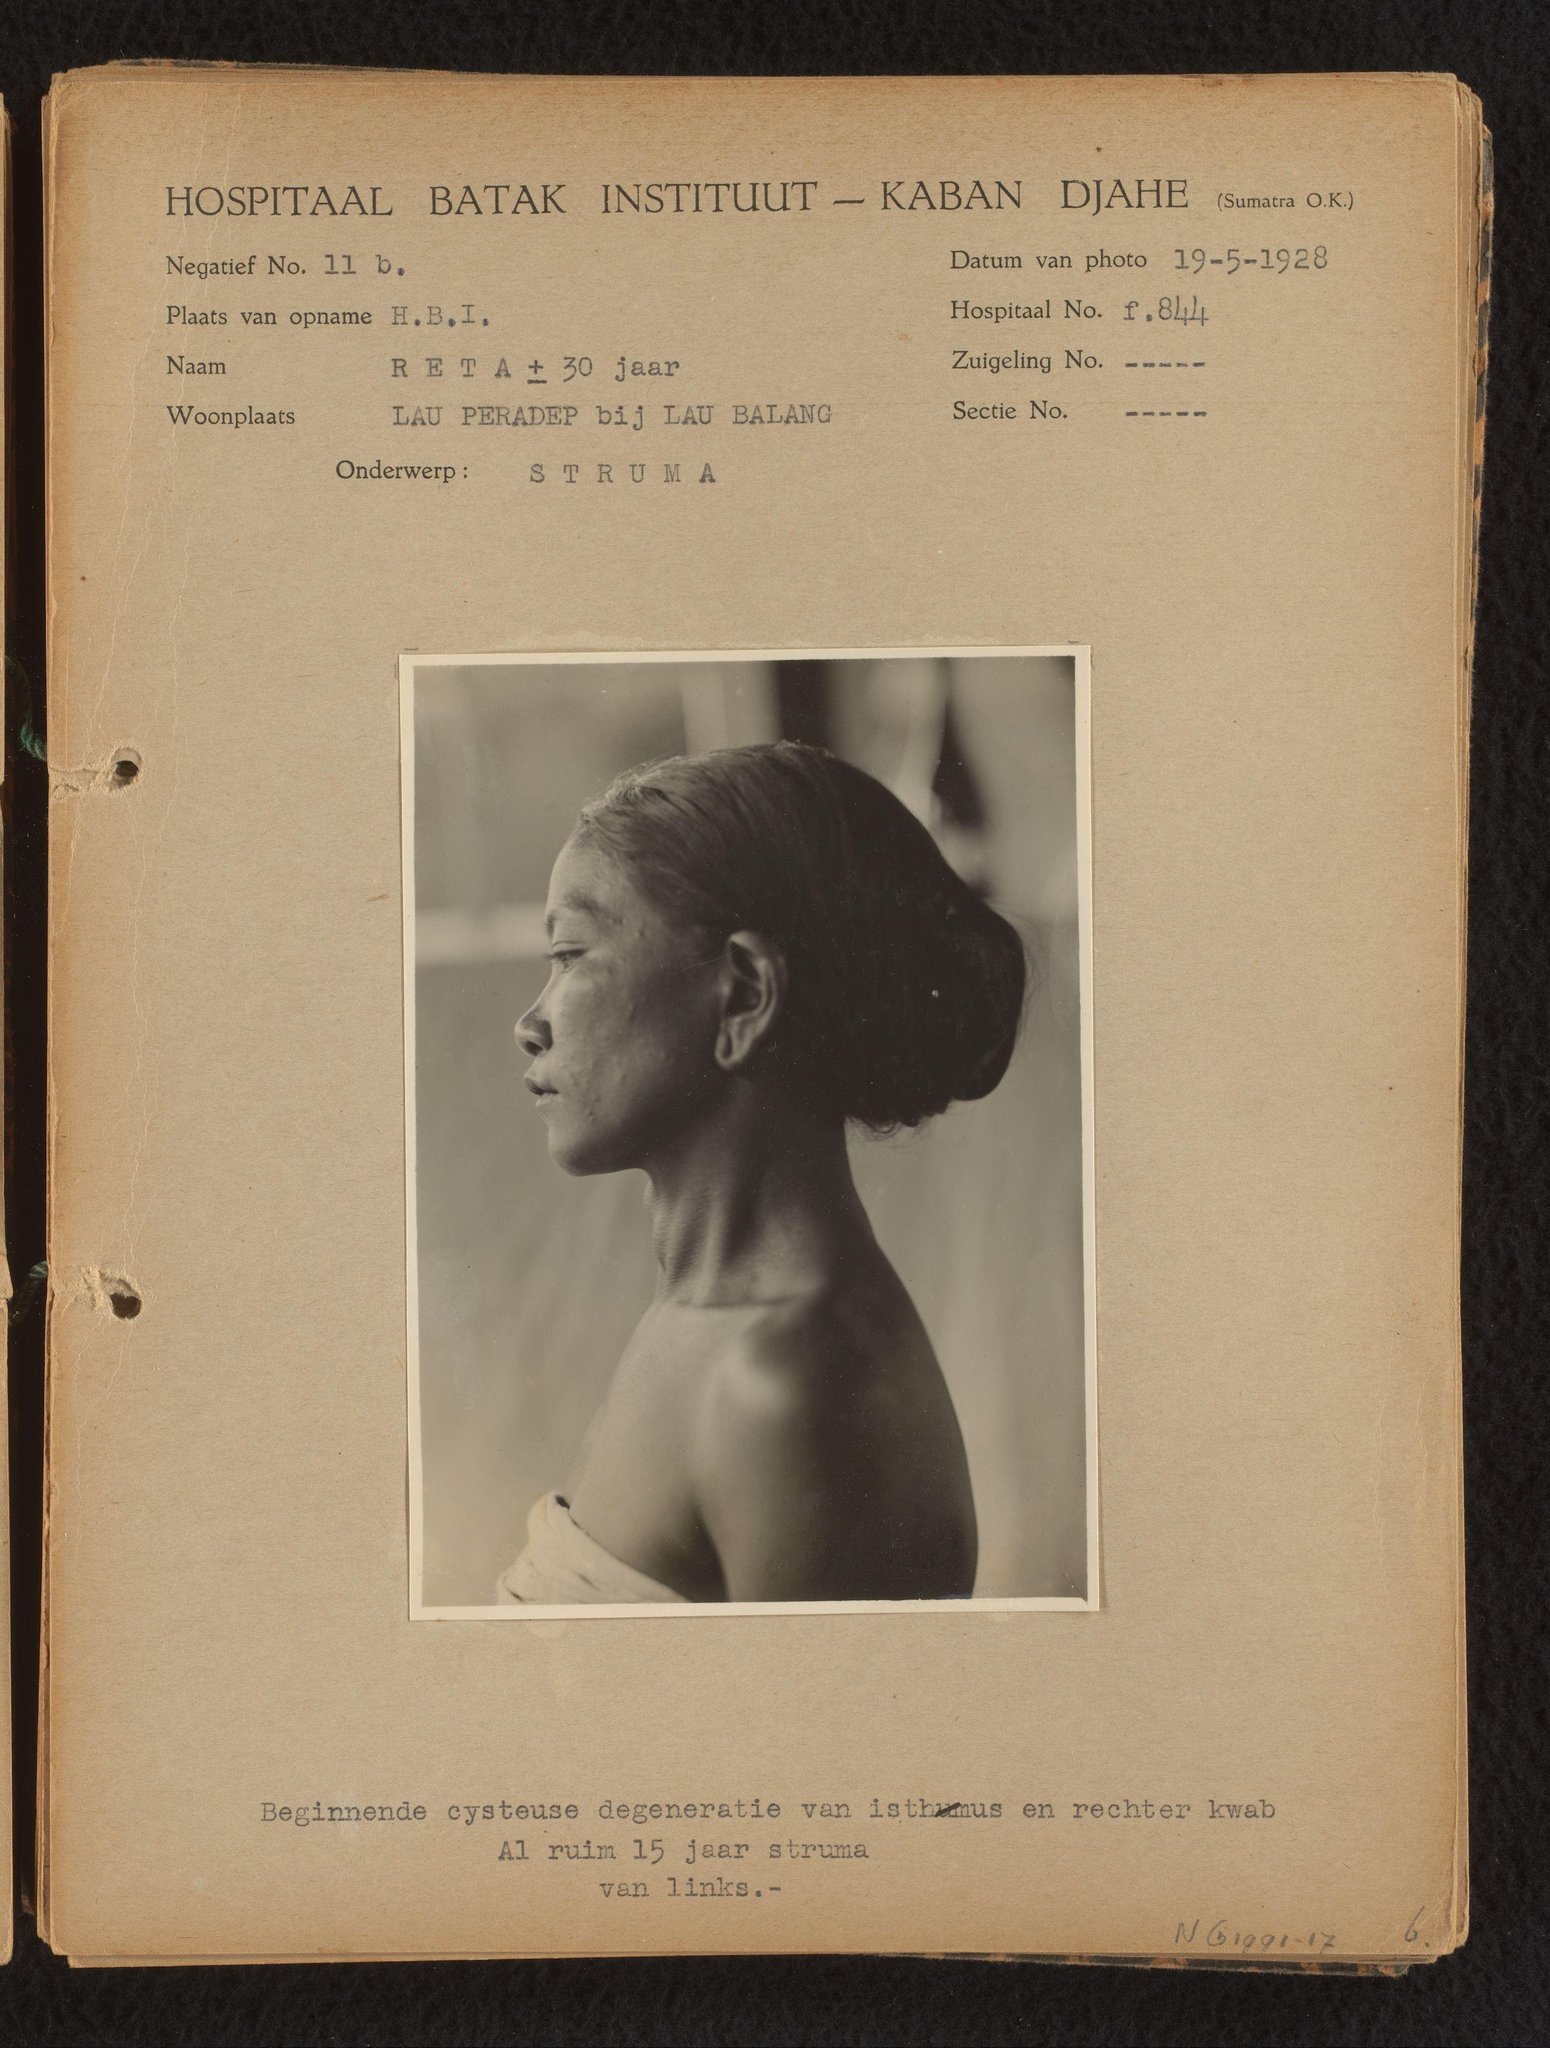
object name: photograph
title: Jonge vrouw met struma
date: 1928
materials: cardboard, photographic support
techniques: gelatin silver print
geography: kabanjahe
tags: colonial system, patient, sick person, sumatra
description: Medische foto van een vrouwelijke patiënt van ca. 30 jaar genaamd Reta die al 15 jaar struma heeft. Datum foto: 19 mei 1928. Foto geplakt op voorgedrukt kartonnen blad ingebonden in het fotoalbum over het Hospitaal Batak Instituut te Kabanjaheh op Sumatra in de jaren 1926-1929.